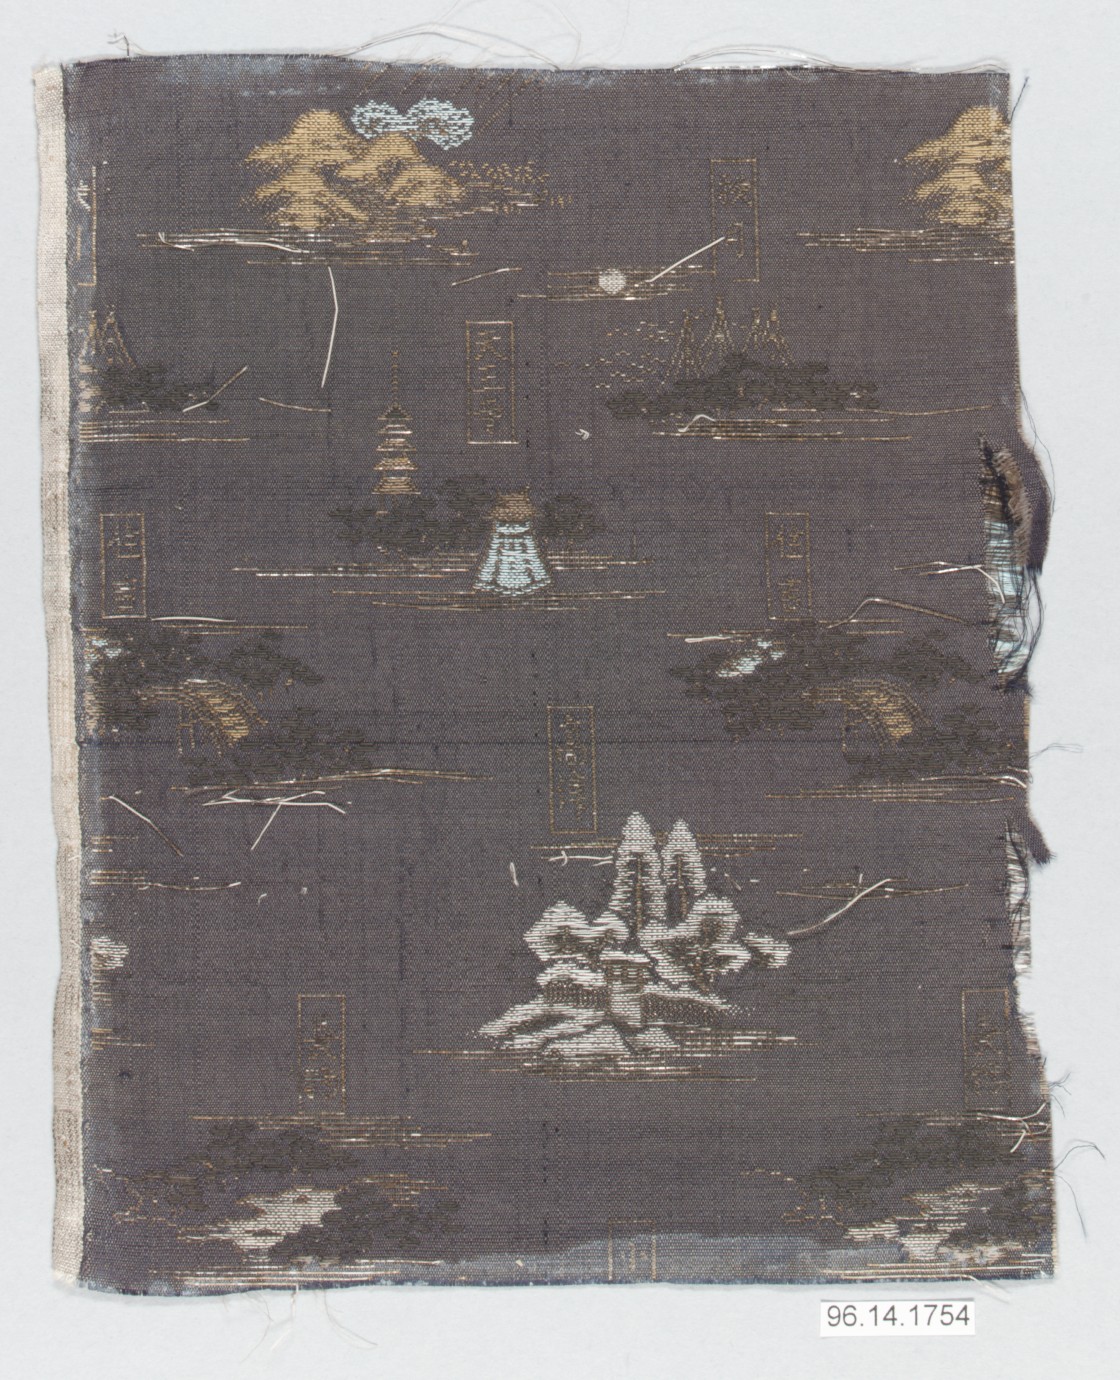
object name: piece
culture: japanese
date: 1701-1900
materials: metal thread, silk